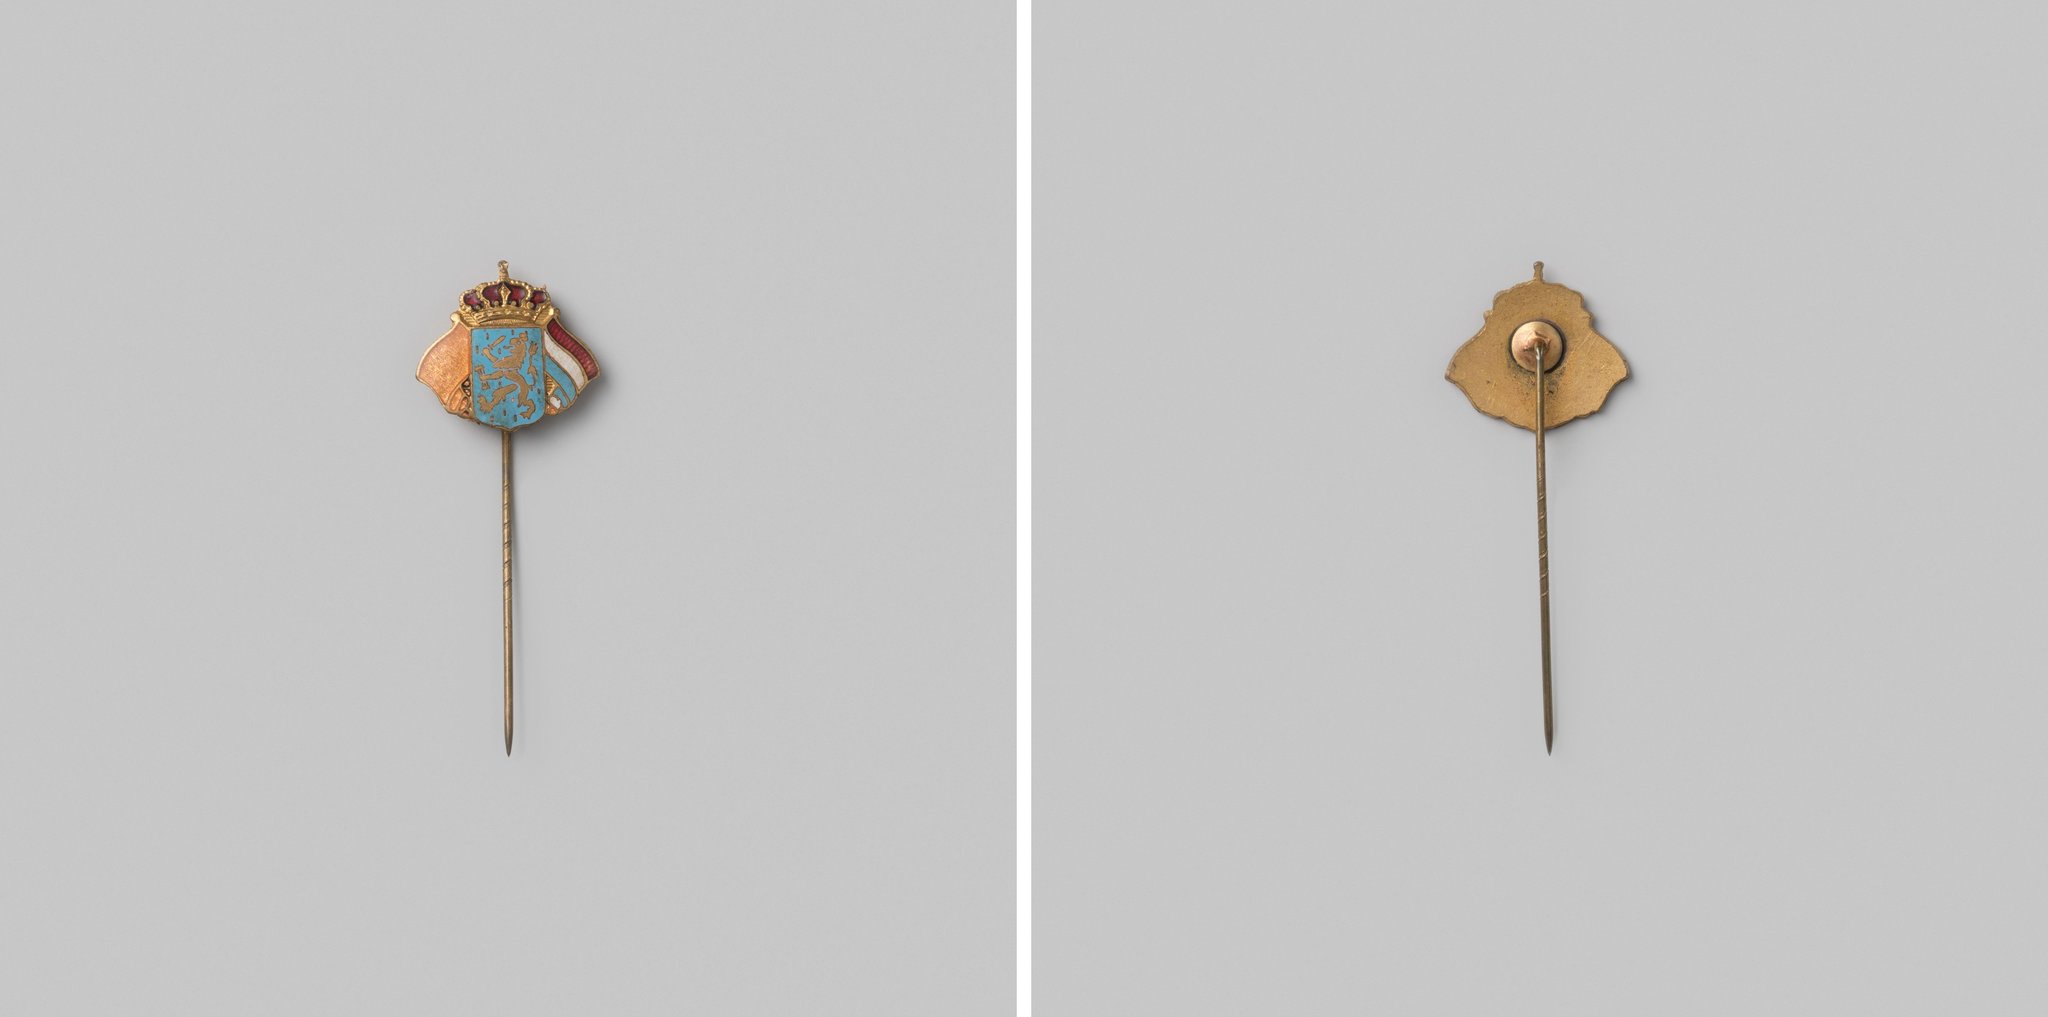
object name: insignia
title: Oranjespeld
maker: Anonymous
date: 1850-1950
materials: metal, paint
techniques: gilding, painting, soldering, striking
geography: netherlands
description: Vergulde gekleurde, eenzijdige plaquette, waaraan een speld is bevestigd, waarvan gedeelte is gedraaid. Voorzijde: gekroond wapenschild, geflankeerd door links oranje vlag en rechts door rood-wit-blauwe vlag. Keerzijde: blanco.